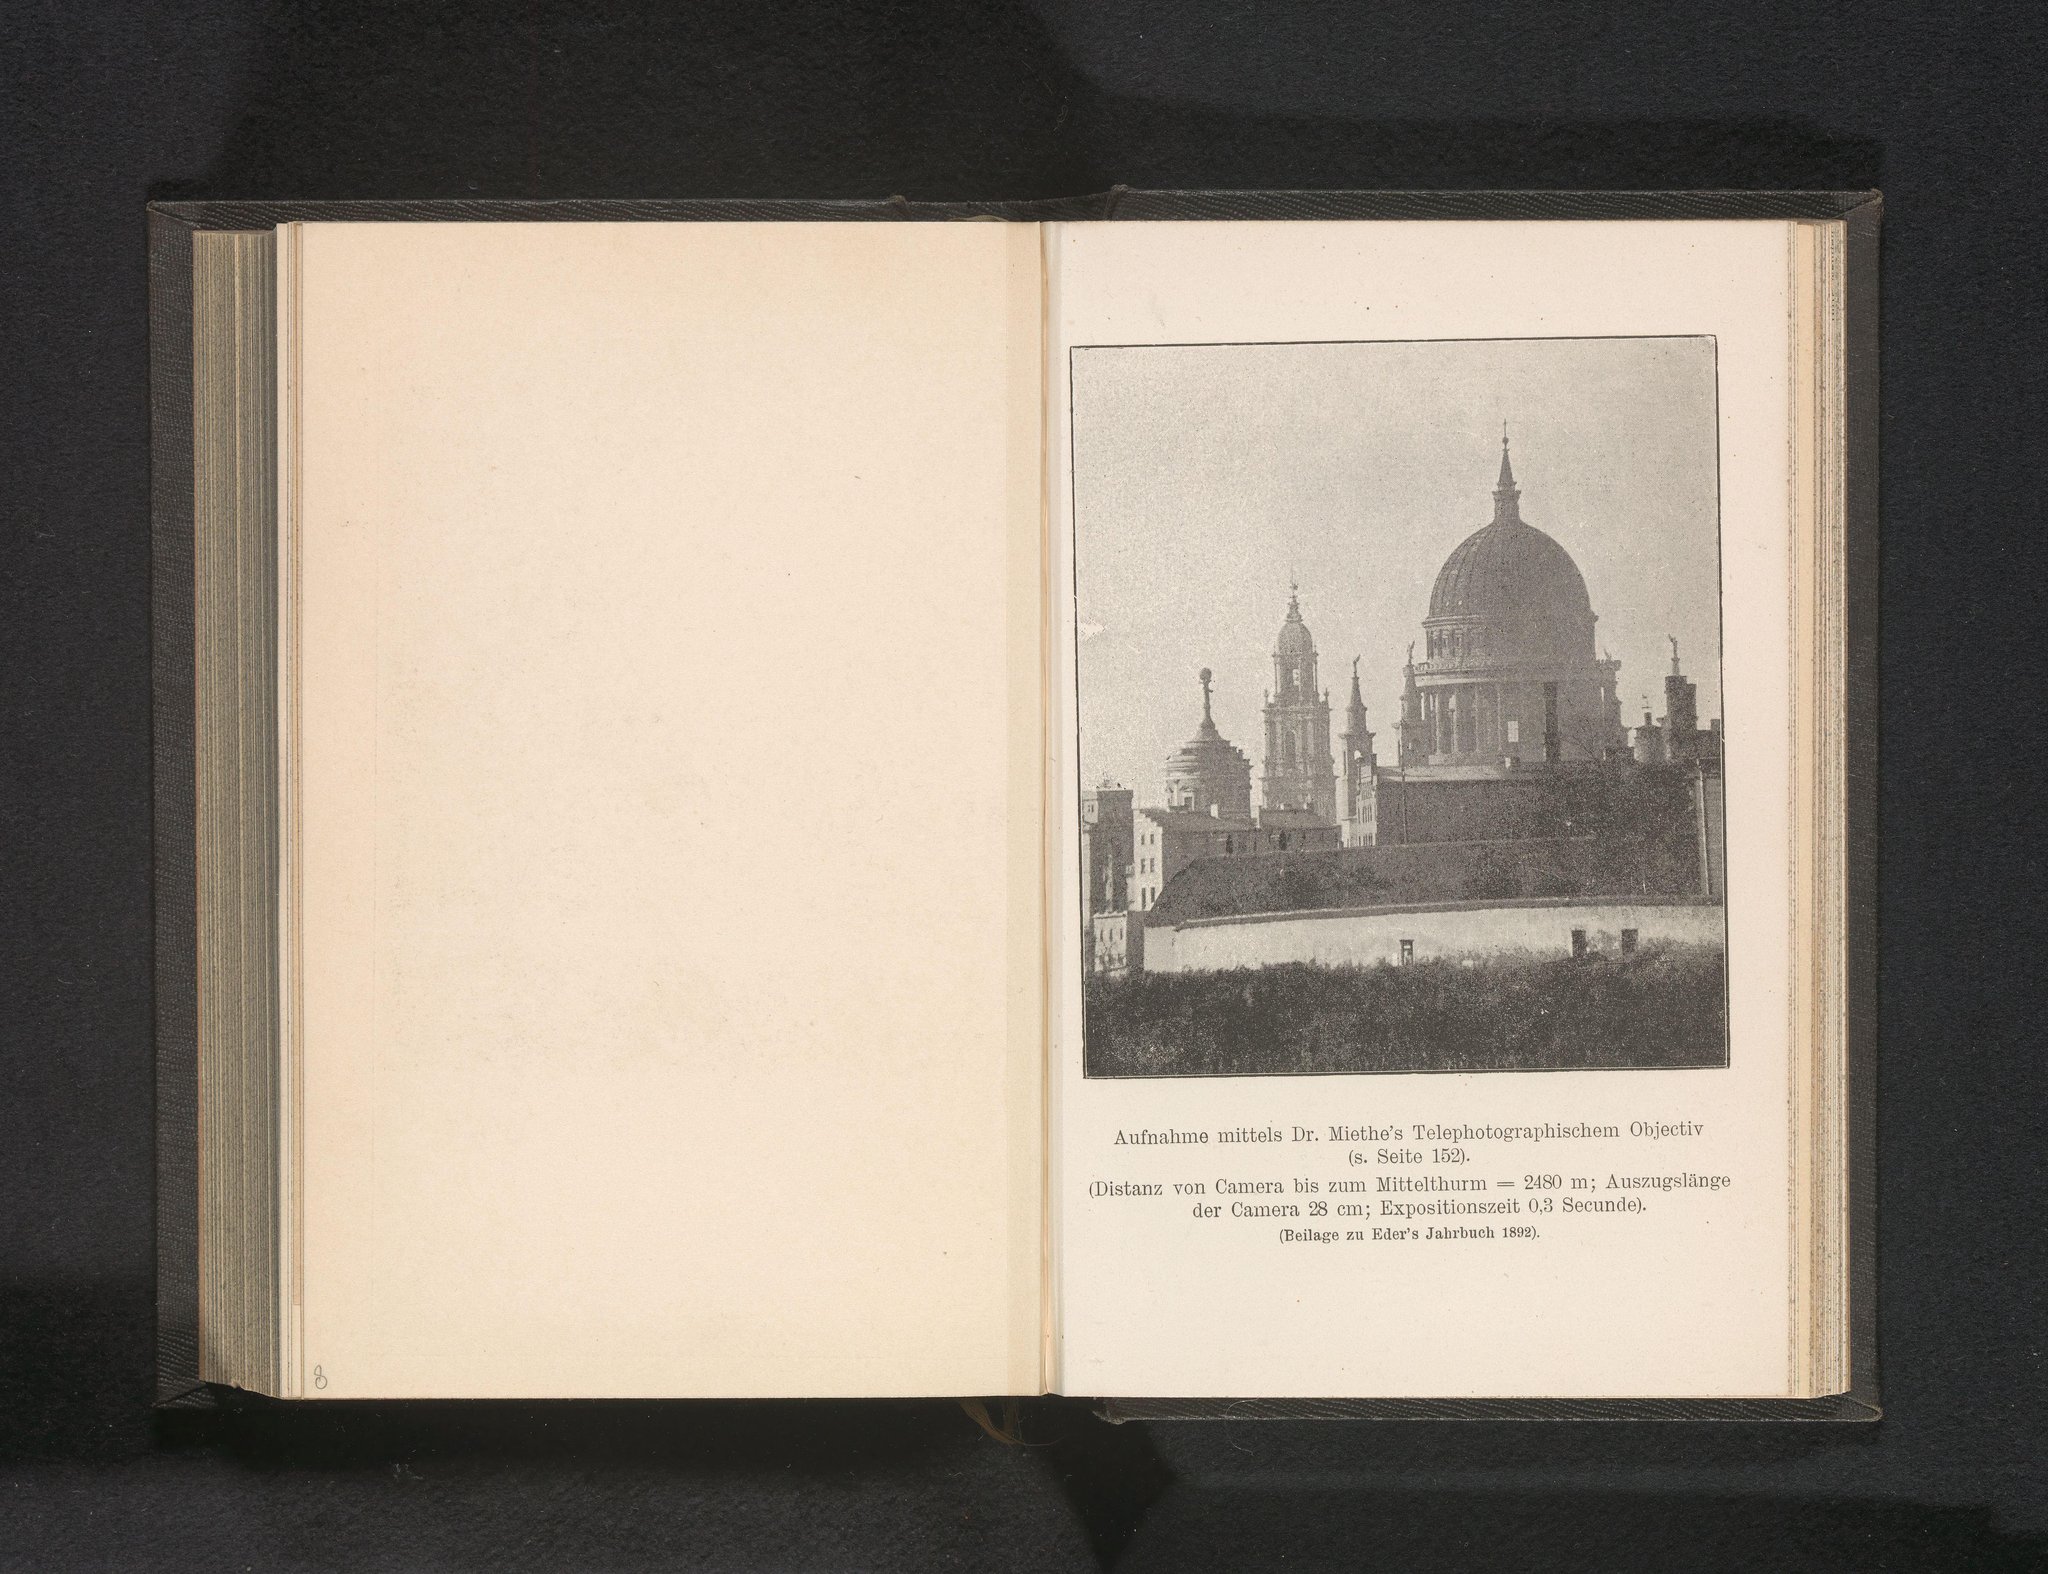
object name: photomechanical print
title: Stadsgezicht met kathedraal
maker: Anonymous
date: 1887-1892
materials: paper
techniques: autotype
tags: city-view in general; 'veduta', church (exterior)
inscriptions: inscription: ‘Aufnahme mittels Dr. Miethe's Telephotographischem Objectiv (s. Seite 152) (...)’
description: Prent op zeventiende ongenummerde pagina na pagina 520.